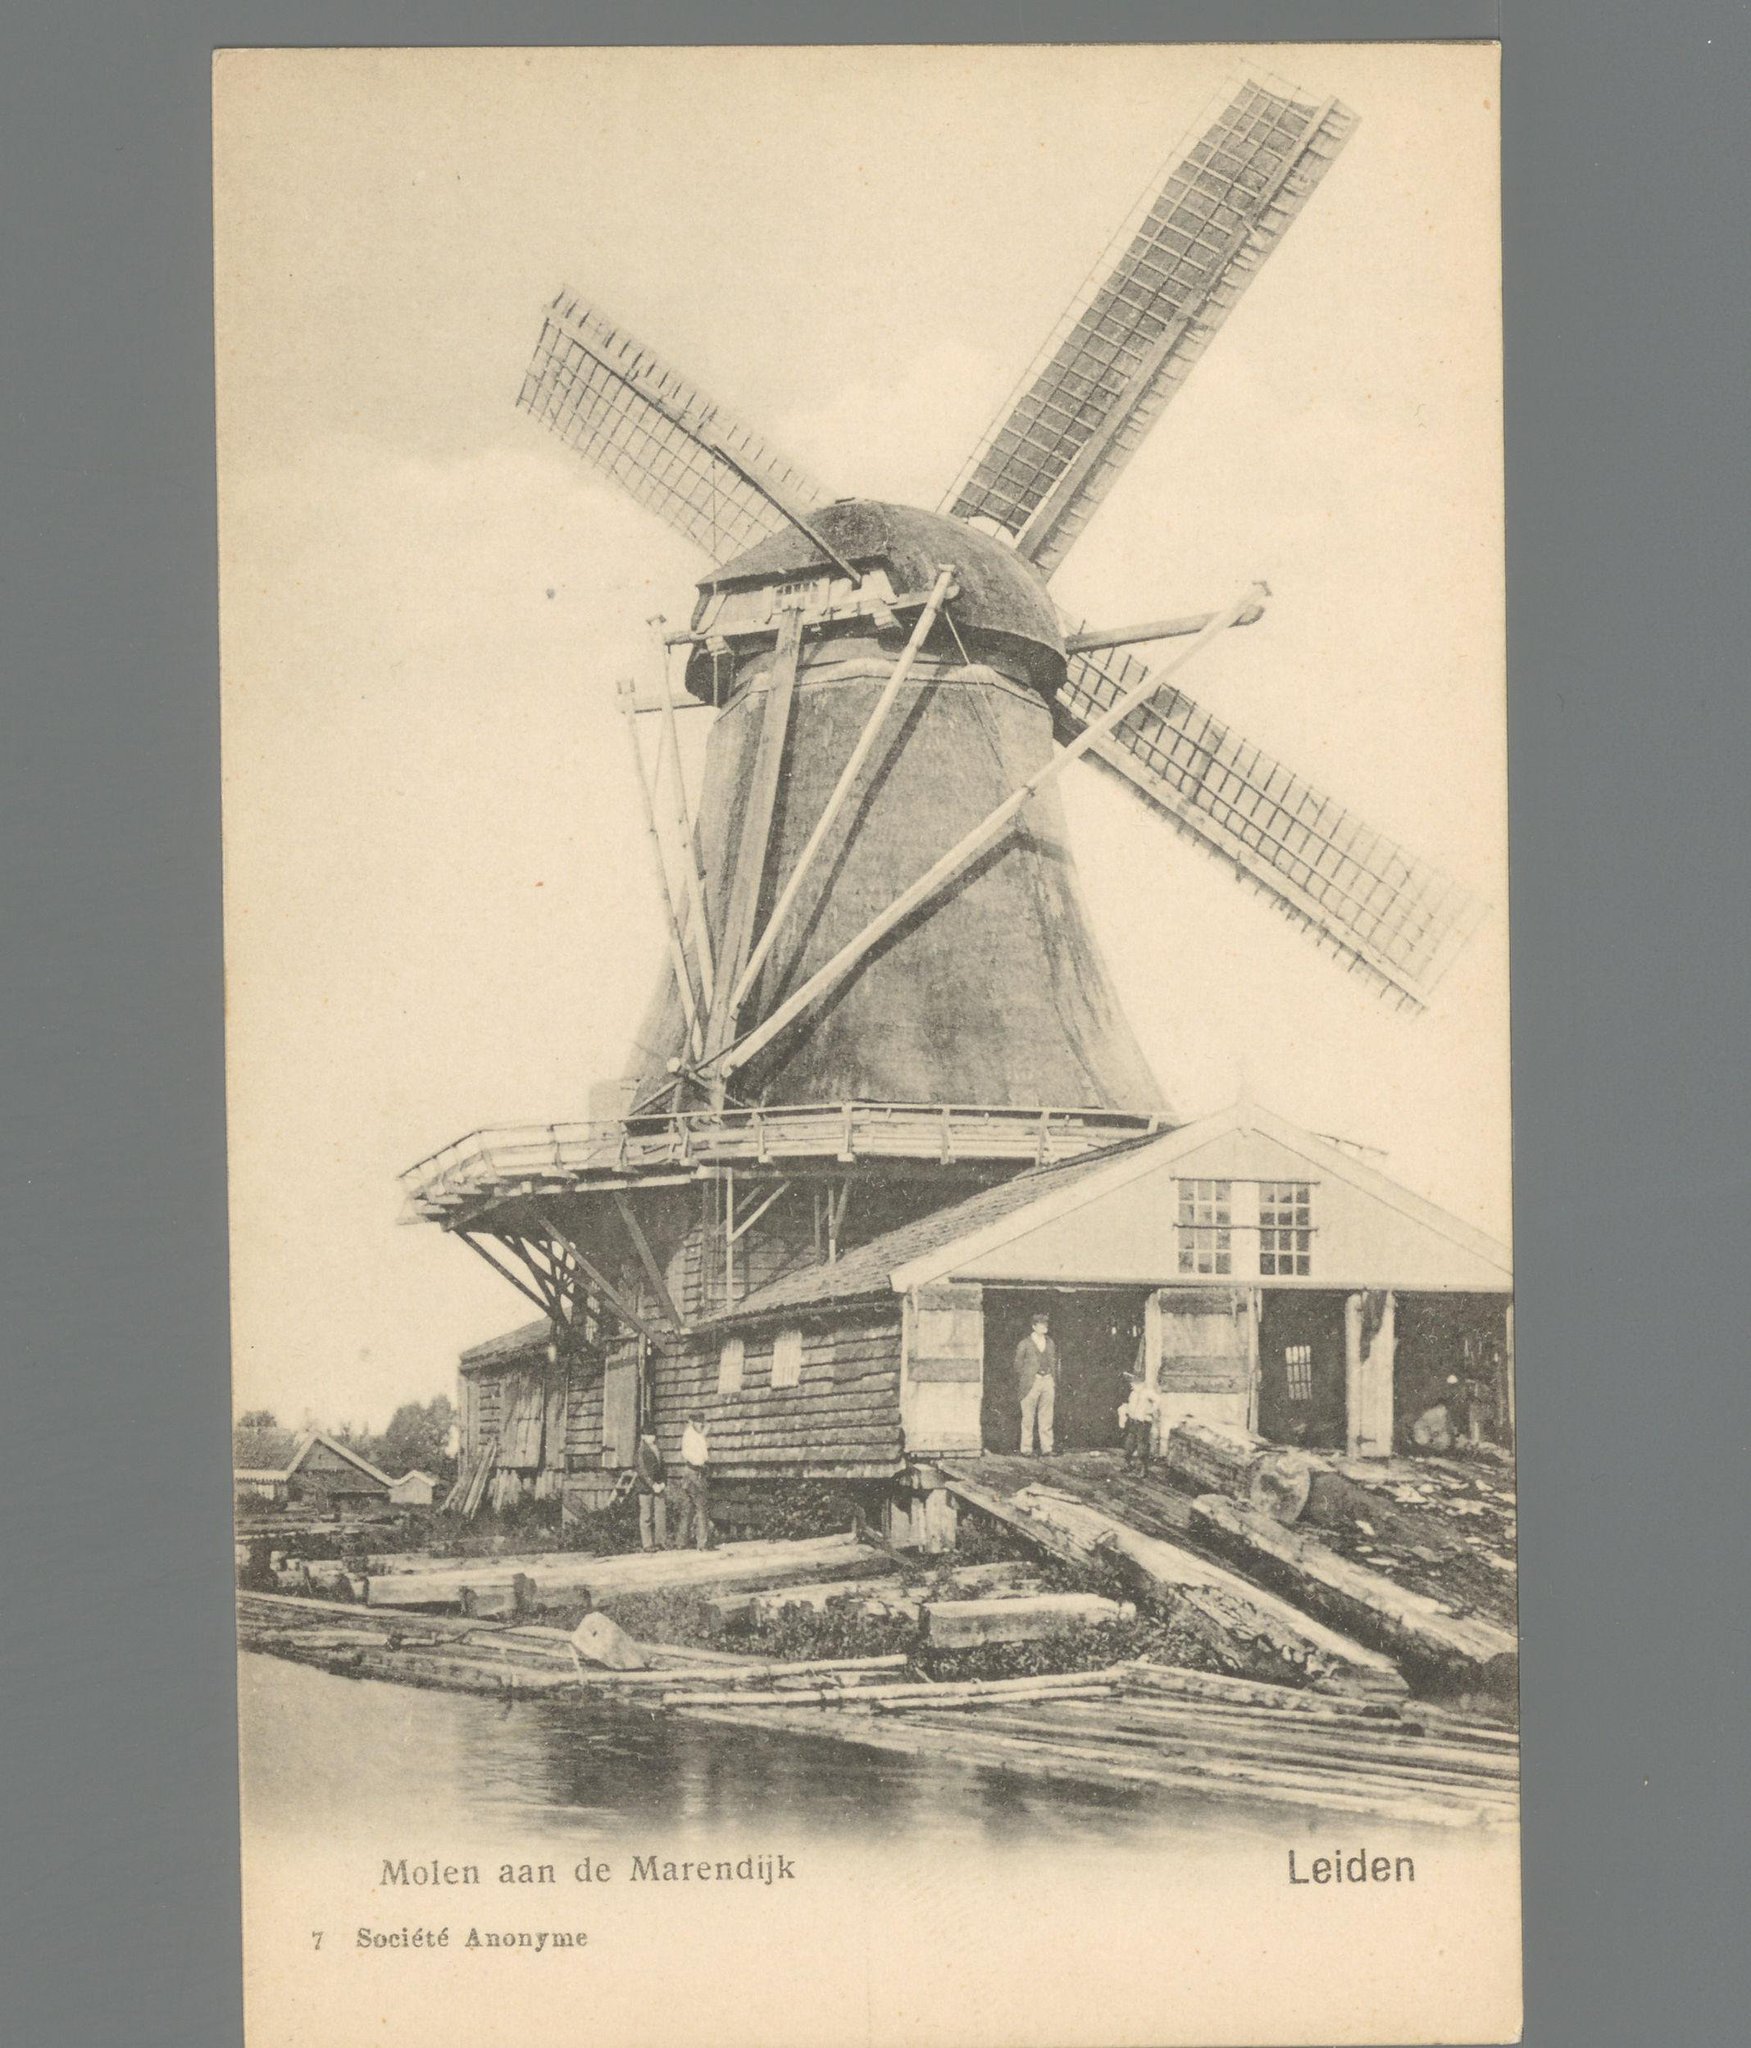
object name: photomechanical print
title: Molen aan de Marendijk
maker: Anonymous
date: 1897-1905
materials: cardboard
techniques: photograph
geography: leiden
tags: windmill, leiden